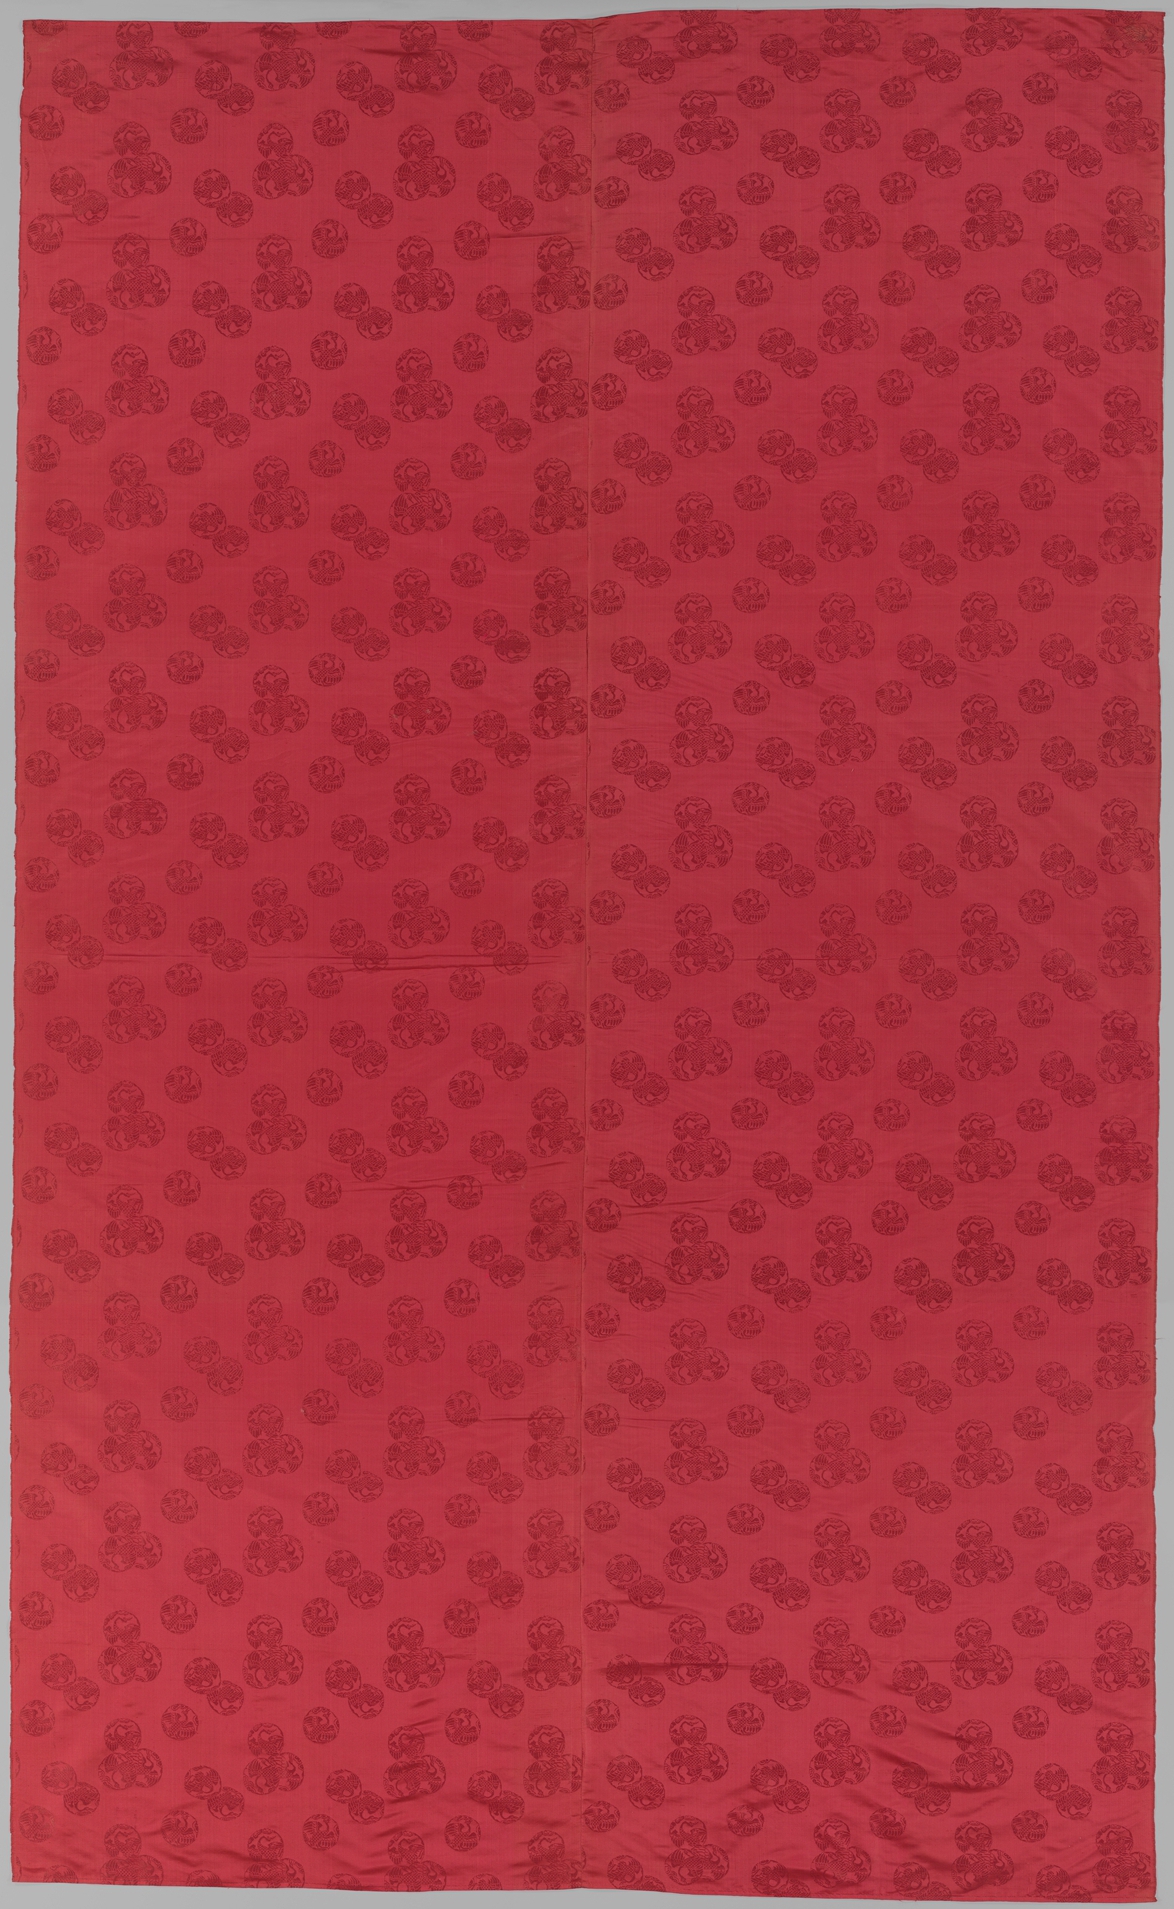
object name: fabric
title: Panel (see also 1975.1.1933)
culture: chinese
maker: chinese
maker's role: artist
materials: silk